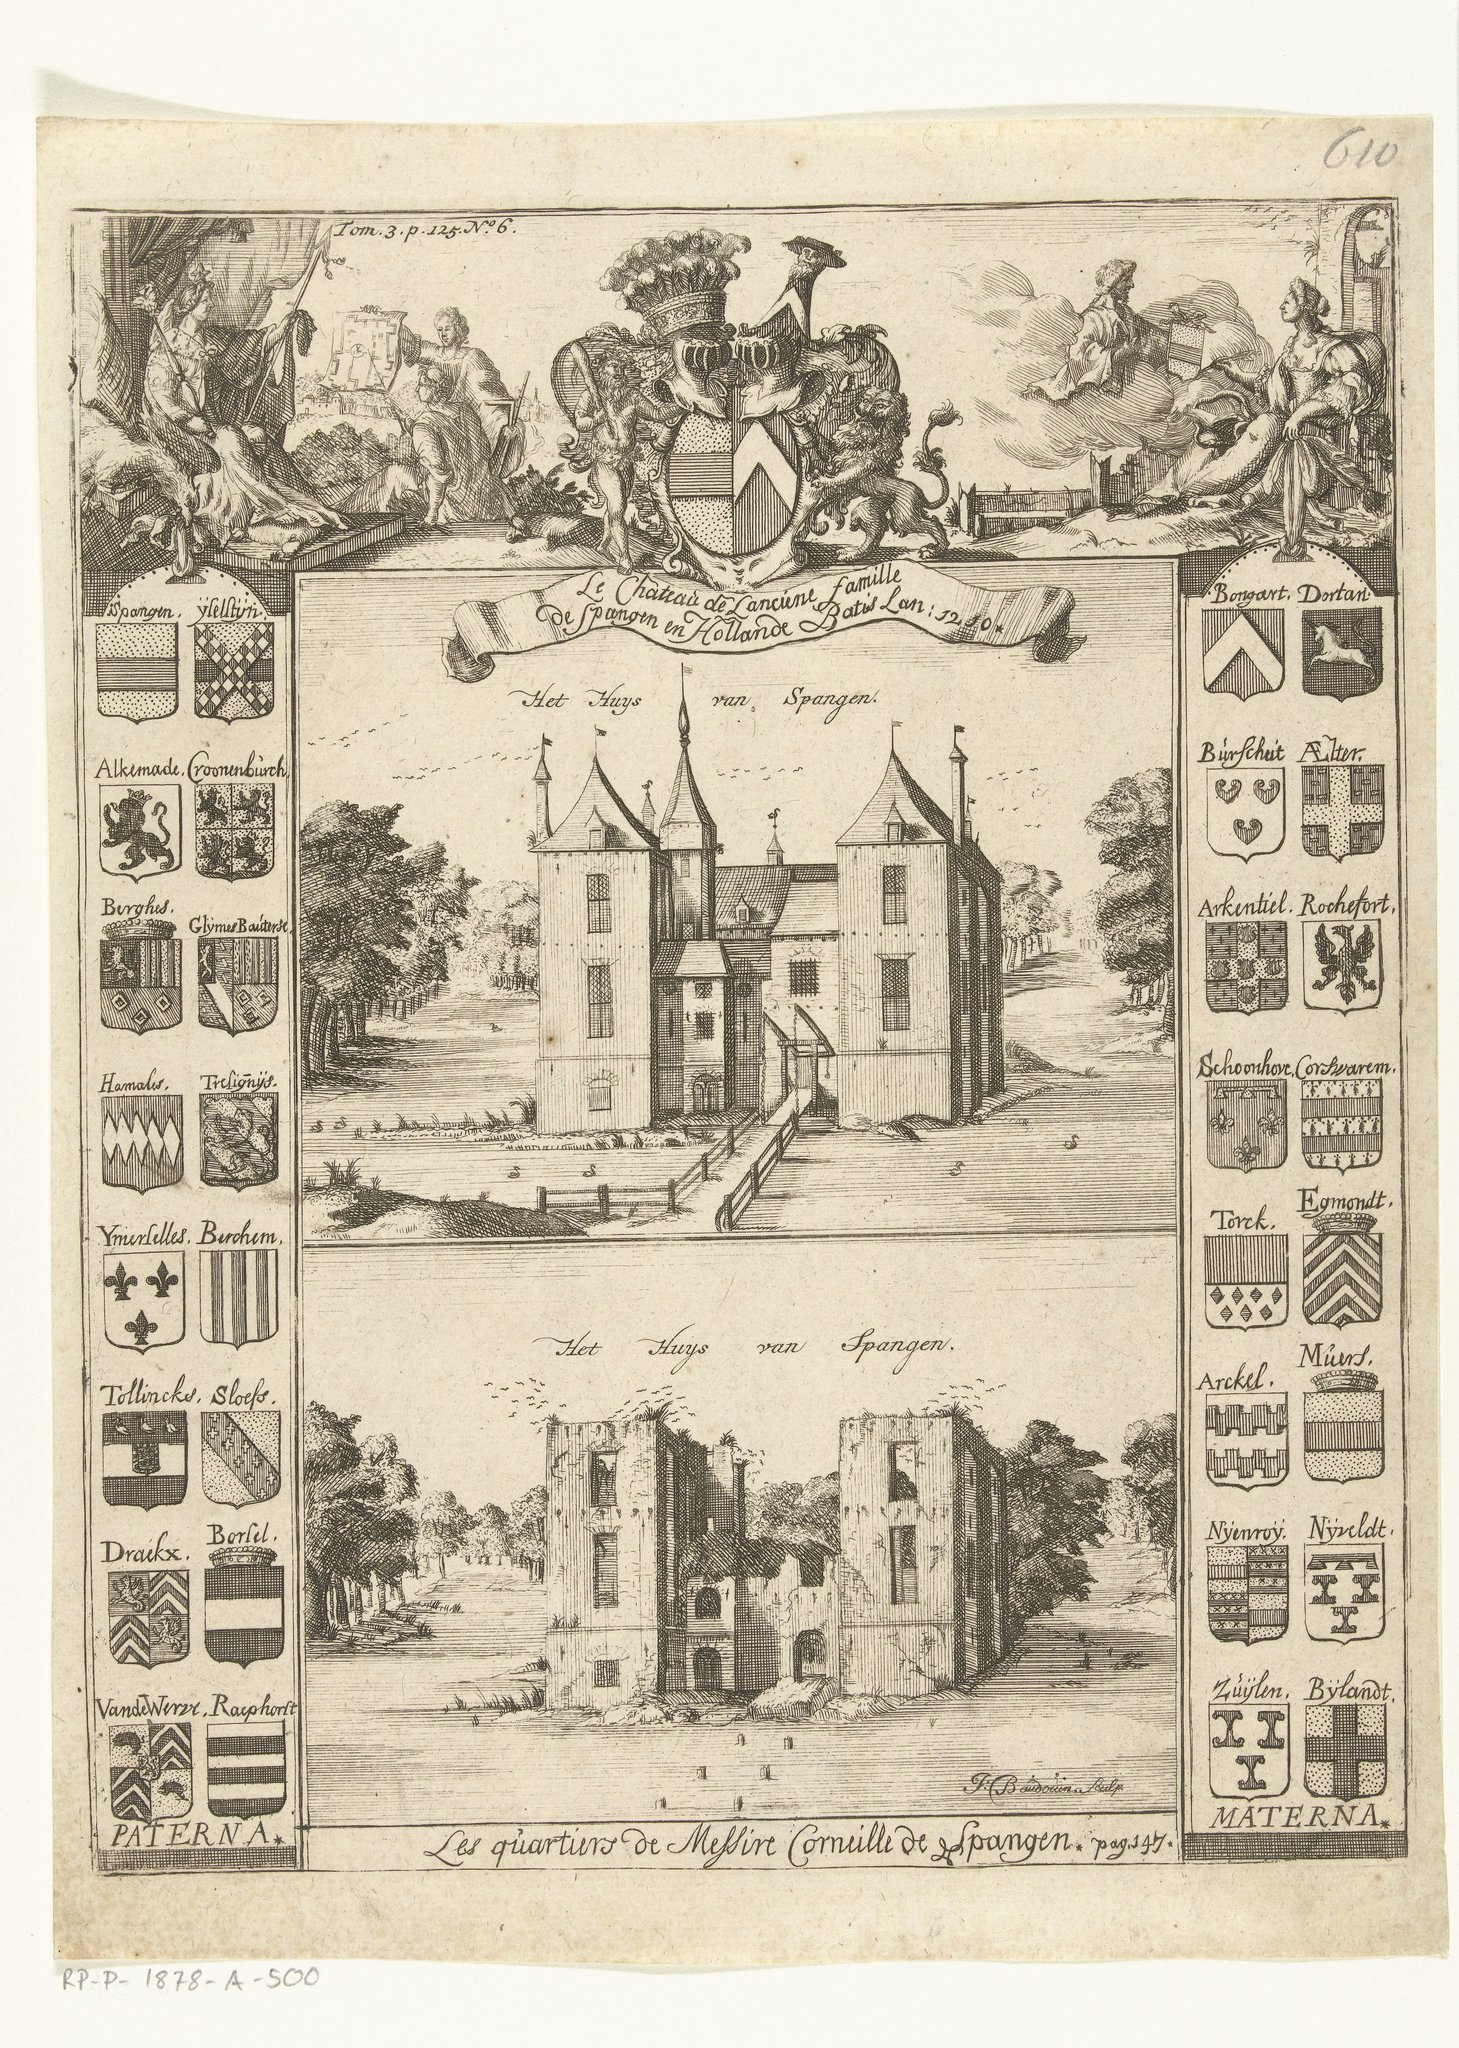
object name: print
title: Huis van Spangen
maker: i. baudouin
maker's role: print maker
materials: paper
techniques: etching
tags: castle, ruin of a dwelling, house, castle, etc.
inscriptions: collector's mark: Lugt 2228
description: Twee voorstellingen met het huis van Spangen boven elkaar. Boven het huis in goede tijden, onder als ruïne. Aan weerszijden 32 familiewapens, links van de kant van Spangen, rechts van de kant van Bongart. Boven het samengestelde wapen van de families Spangen en Bongart en twee allegorische scènes. Links een architect die aan een koningin een plattegrond toont. Rechts een dame die met een schrijfveer het familiewapen van Spangen tekent. Onder een verwijzing naar Cornelis van Spangen.